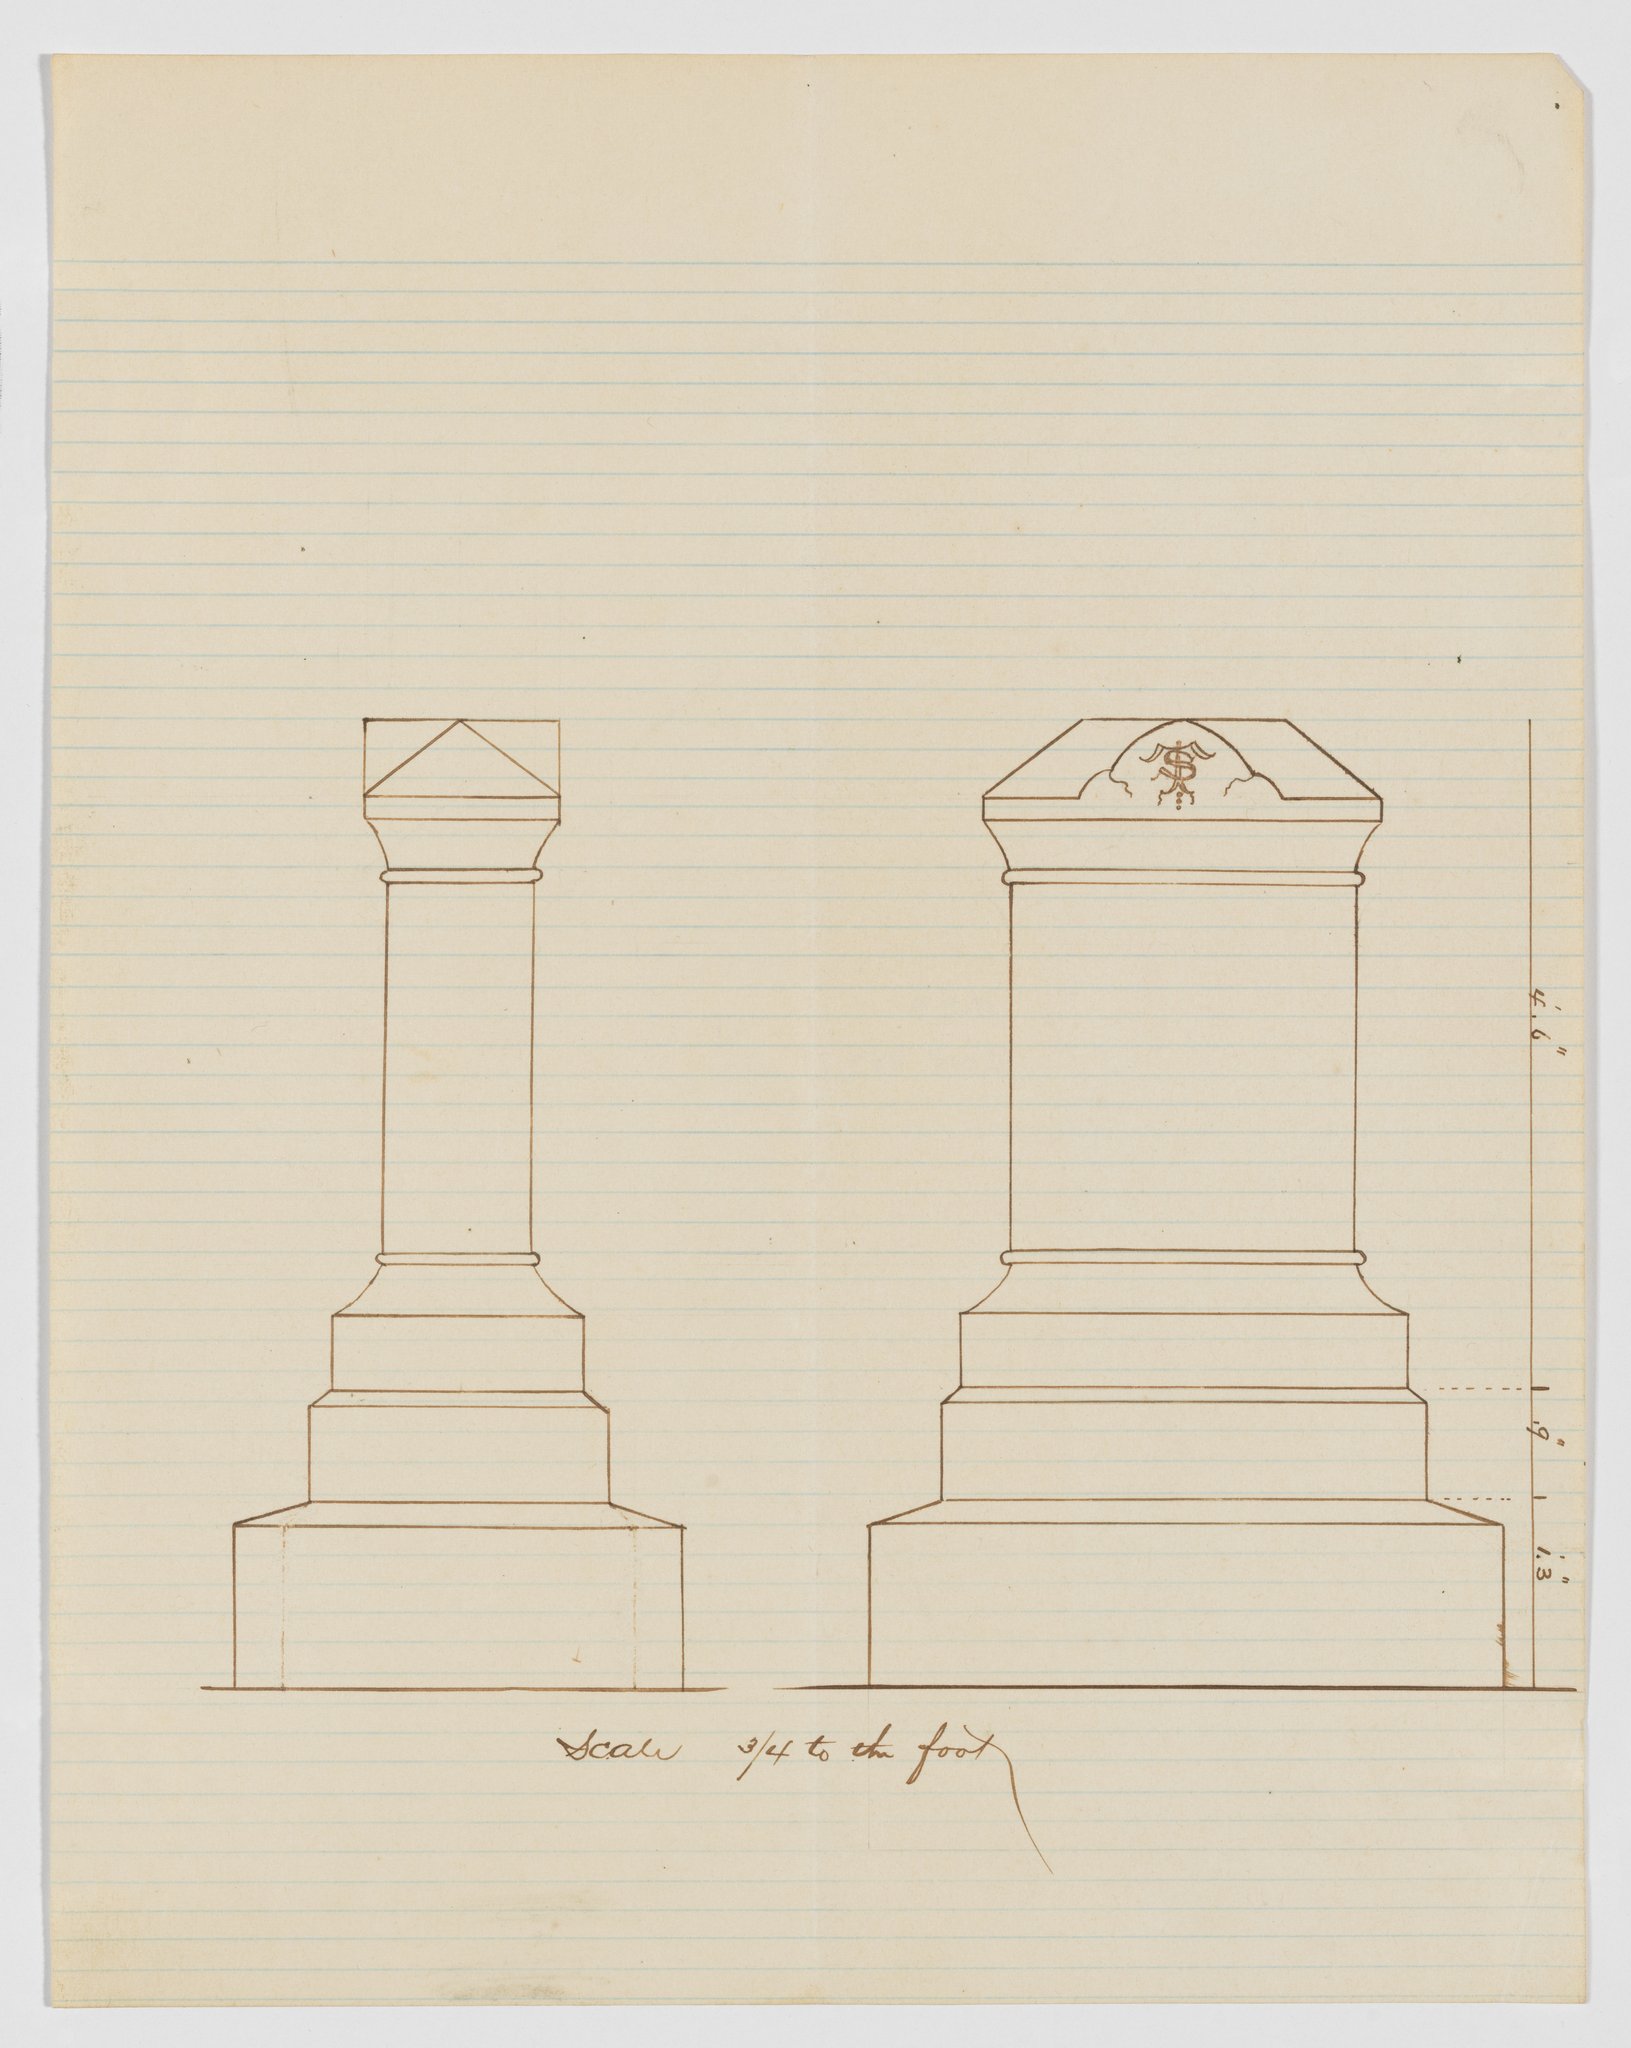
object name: drawing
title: Grave Monument Design (Two Elevations)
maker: alexander maxwell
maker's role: artist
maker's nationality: american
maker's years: 1838-1880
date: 1840-1880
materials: ink